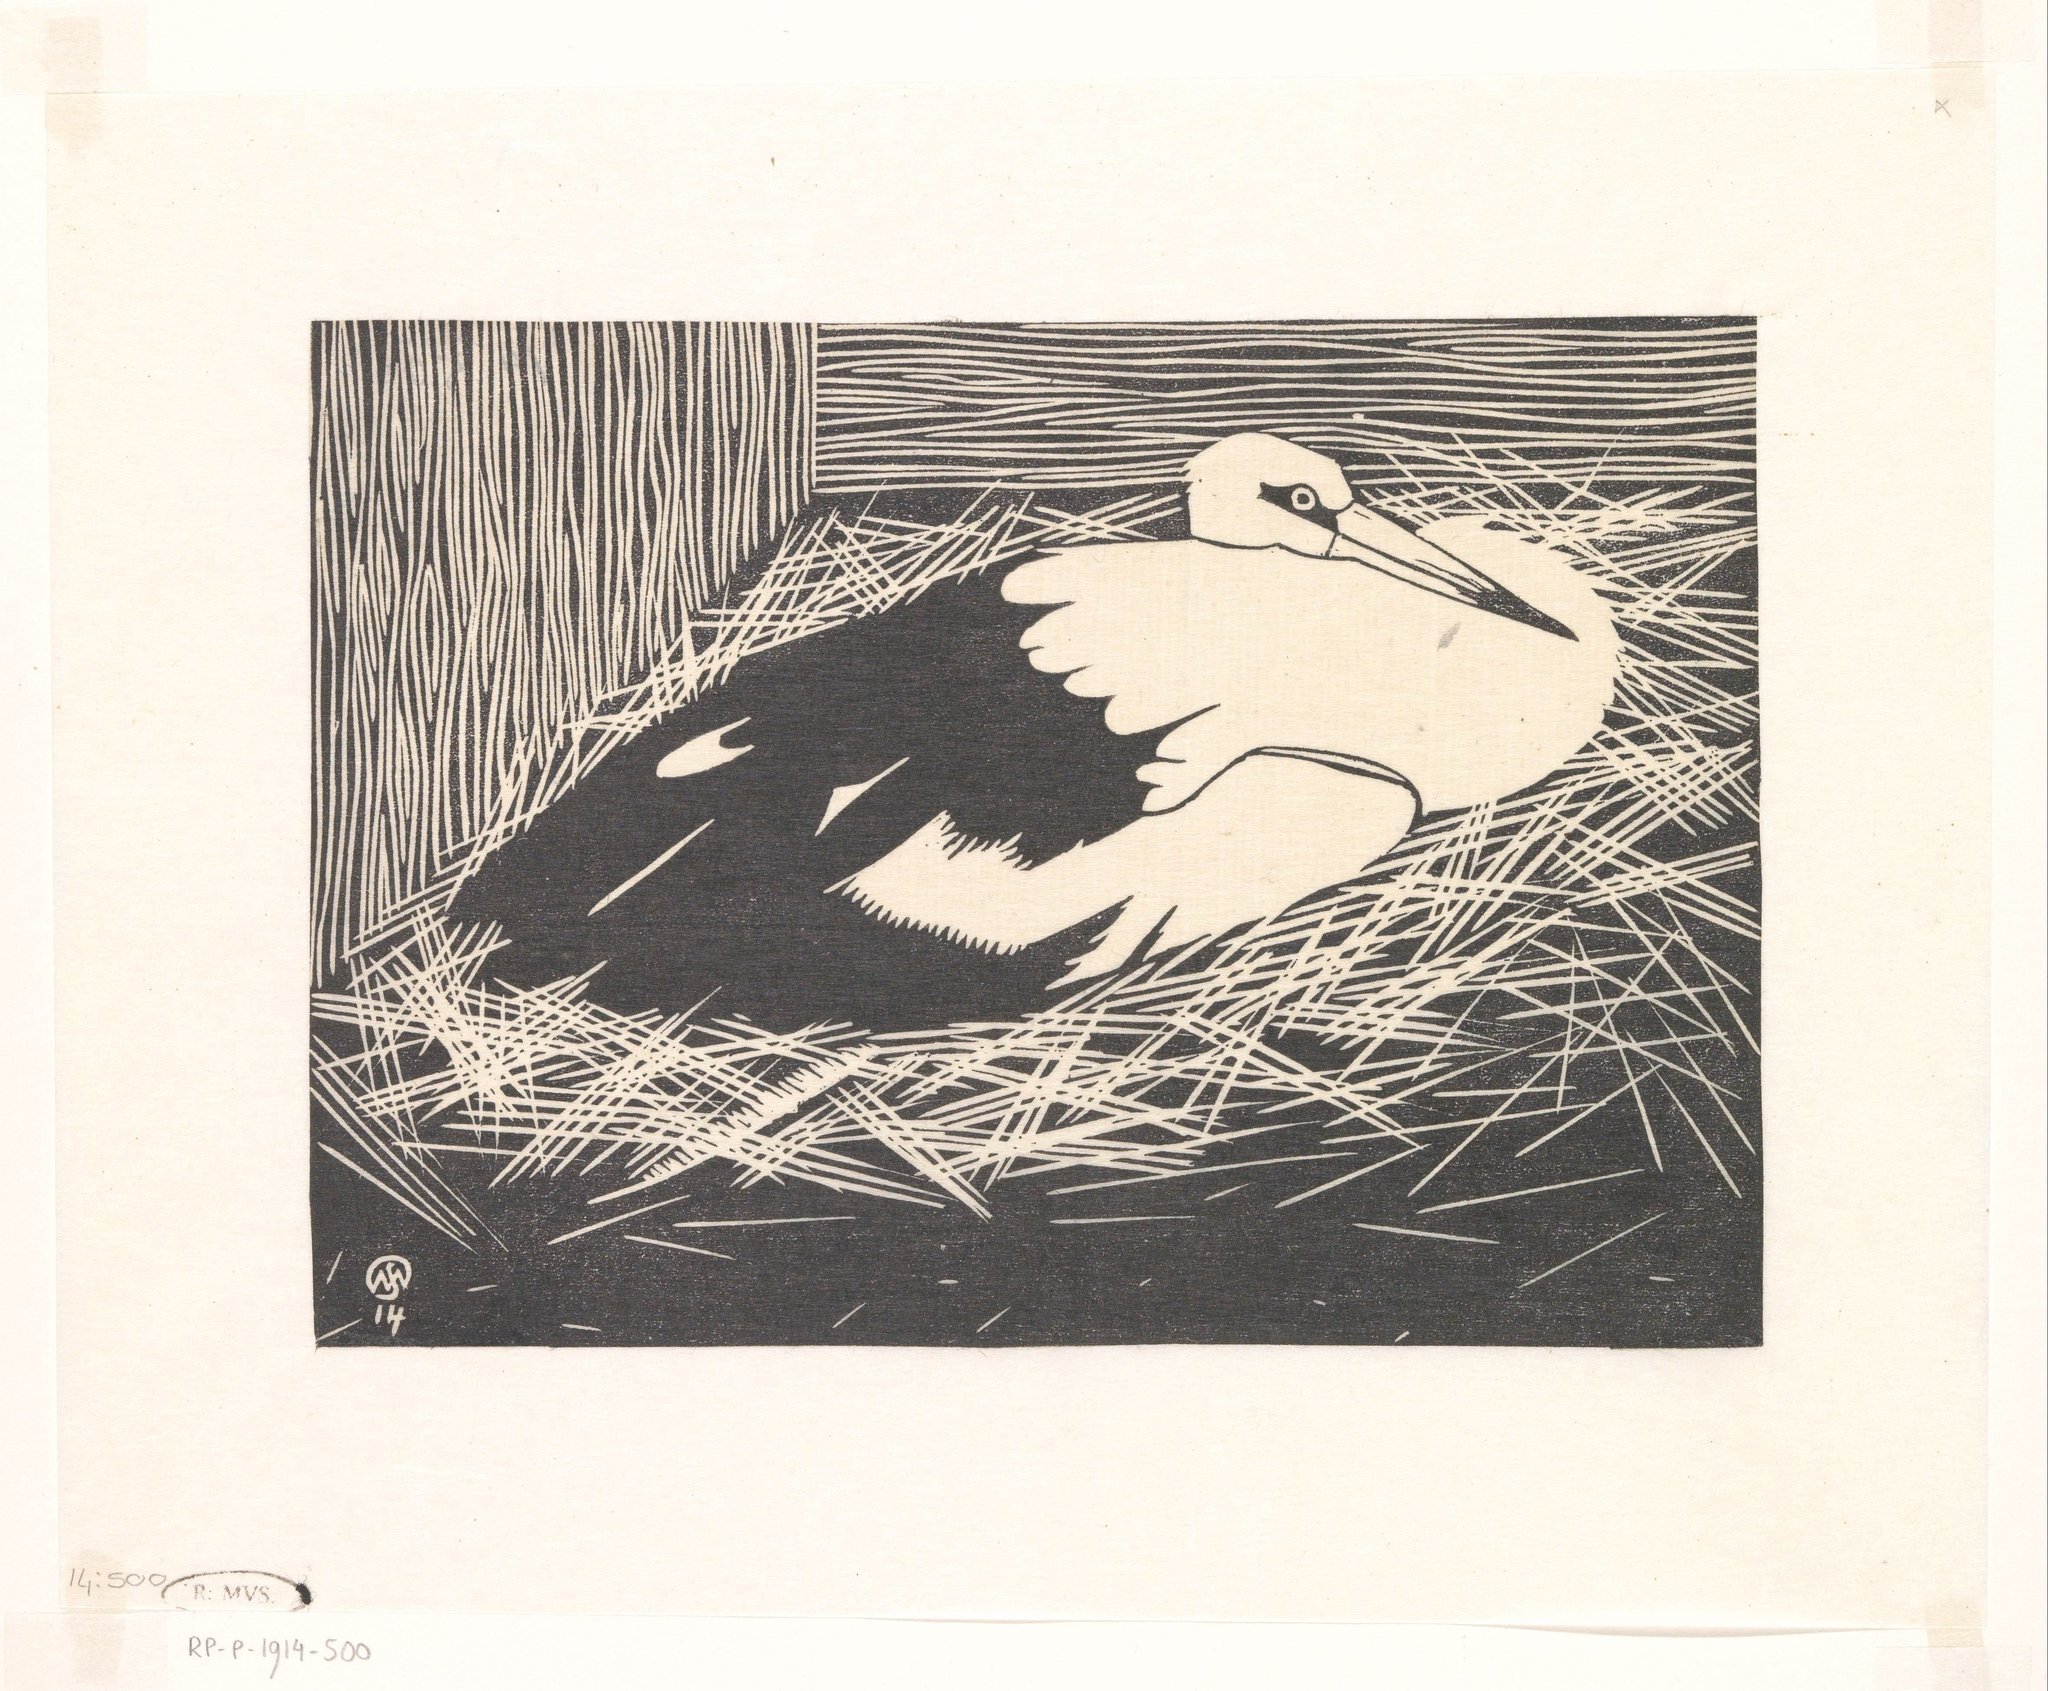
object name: print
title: Ooievaar (Magoear-ooievaar)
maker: samuel jessurun de mesquita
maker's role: draughtsman, print maker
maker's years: 1868-1944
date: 1914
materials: paper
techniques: woodcut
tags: shore-birds and wading-birds: stork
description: Ooievaar liggend in stro in hok van houten platen.